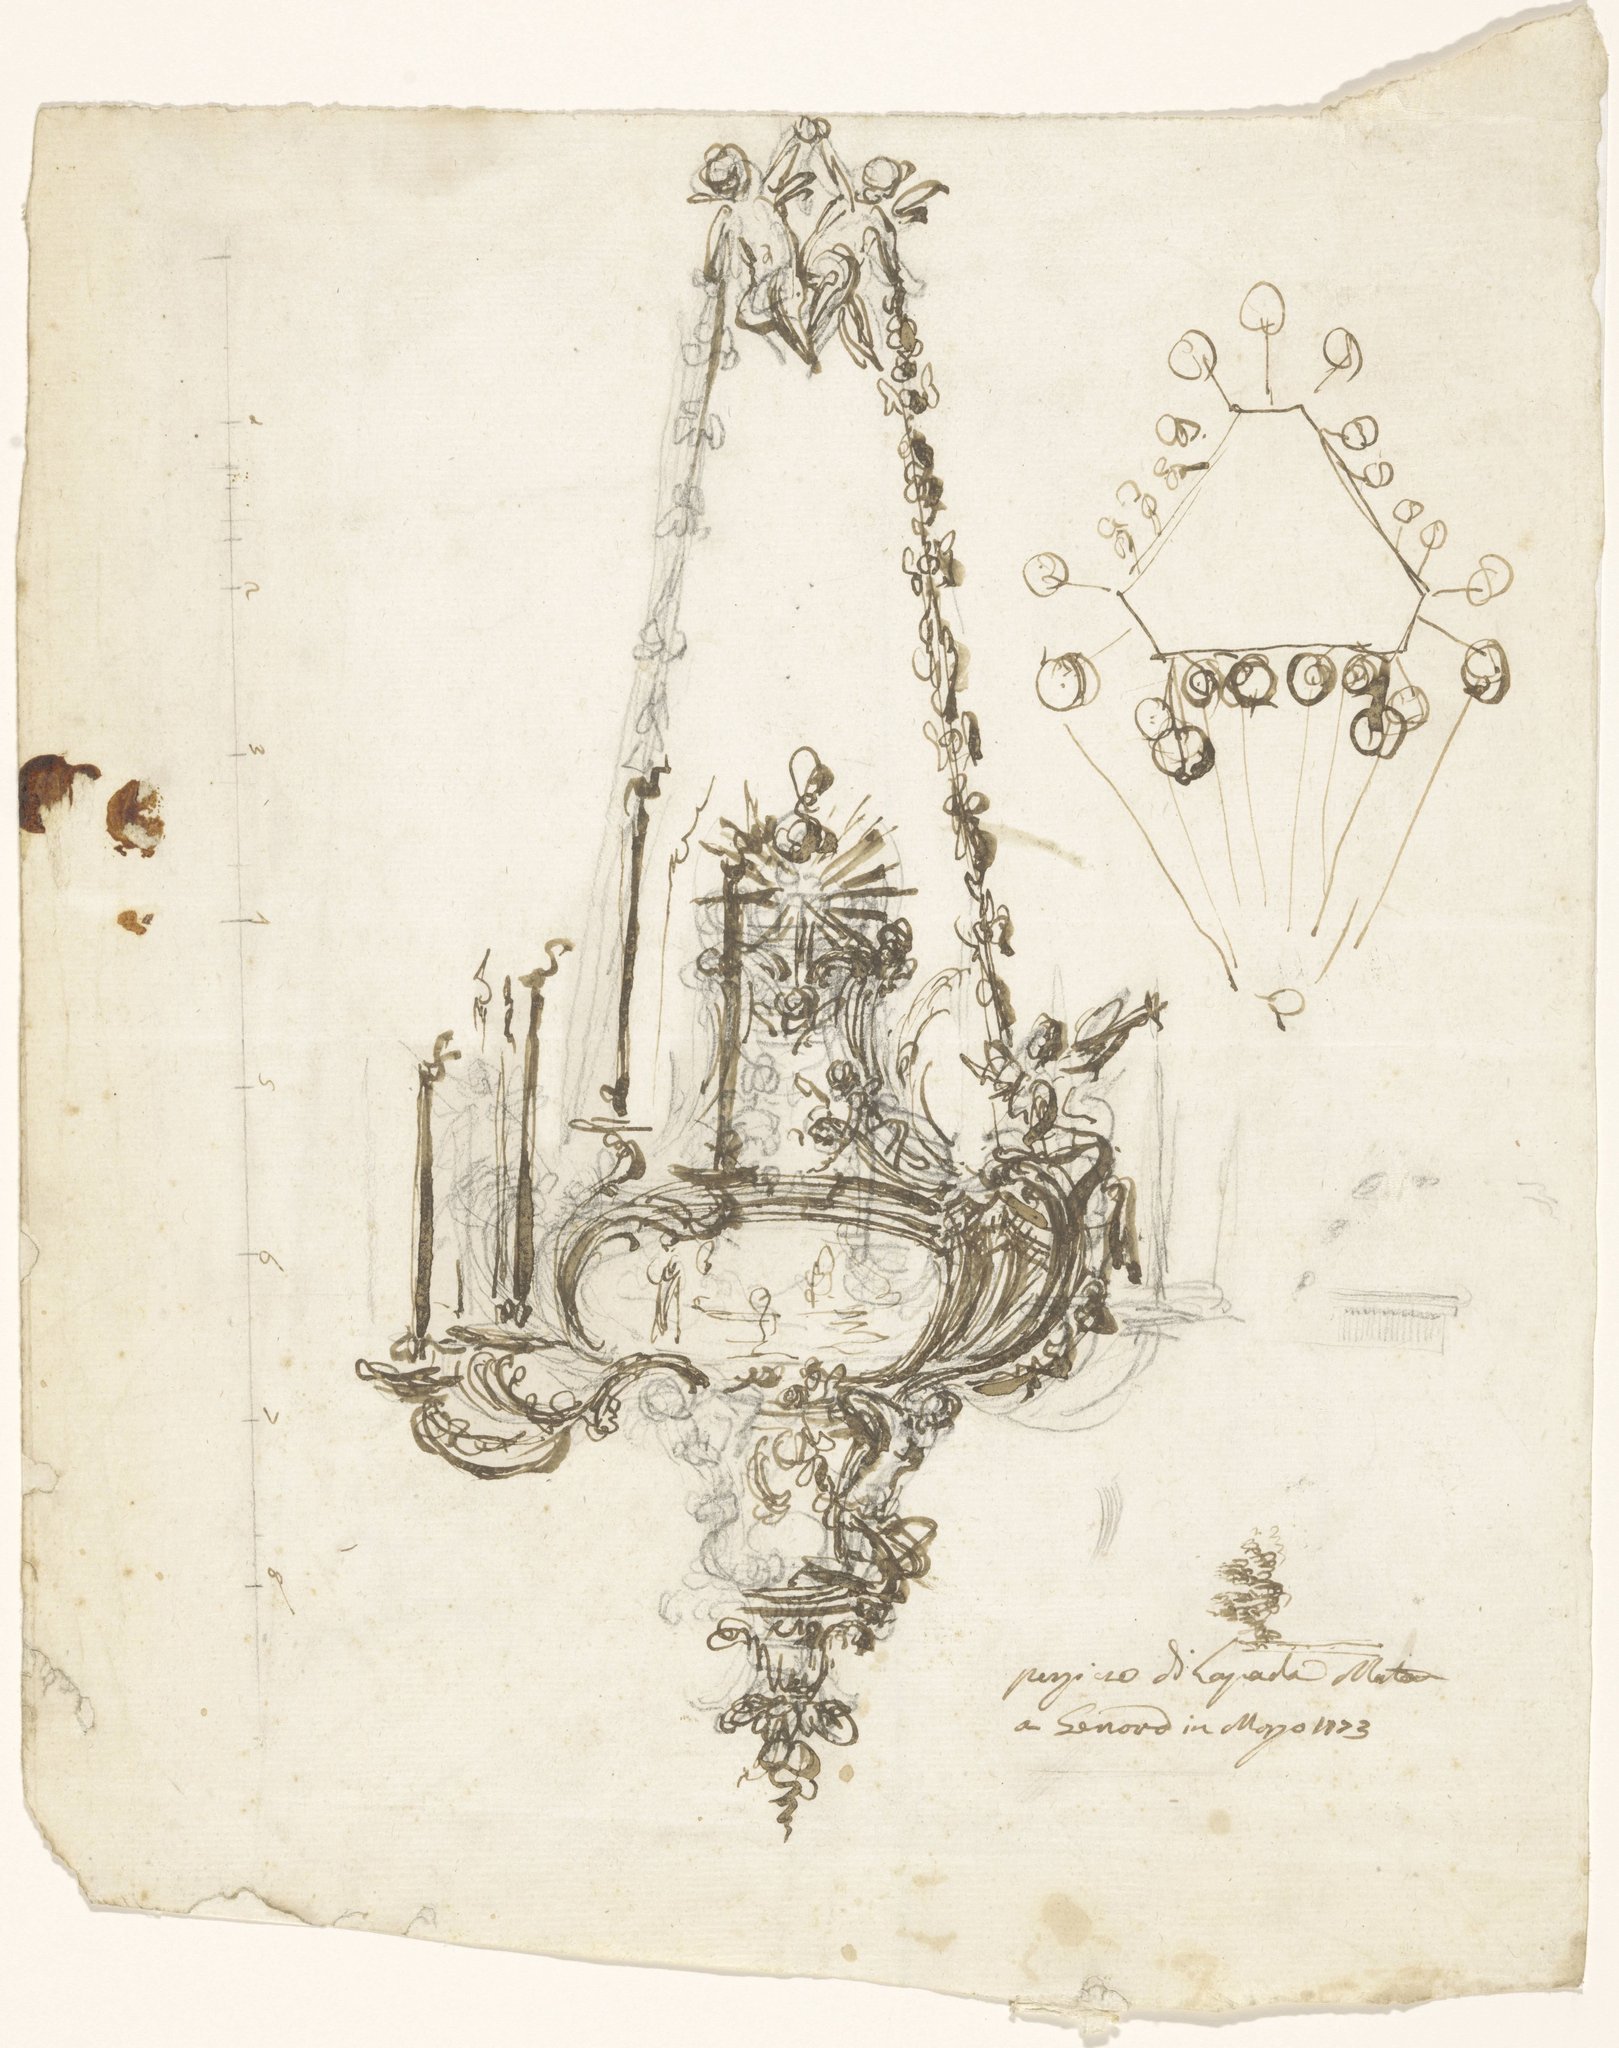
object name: design drawing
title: Ontwerp voor een kerklamp met rechtsboven een doorsnede van het bovenaanzicht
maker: luigi valadier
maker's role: draughtsman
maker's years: 1726-1785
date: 1773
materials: graphite, ink, paper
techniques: pen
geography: rome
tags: chandelier, candelabrum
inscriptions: inscription: ‘pensiero di Lapada Muta / a Genova in Marzo 1773’, inscription, watermark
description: Verso een schets van een kan en een schets van een lantaarn of reliekhouder.